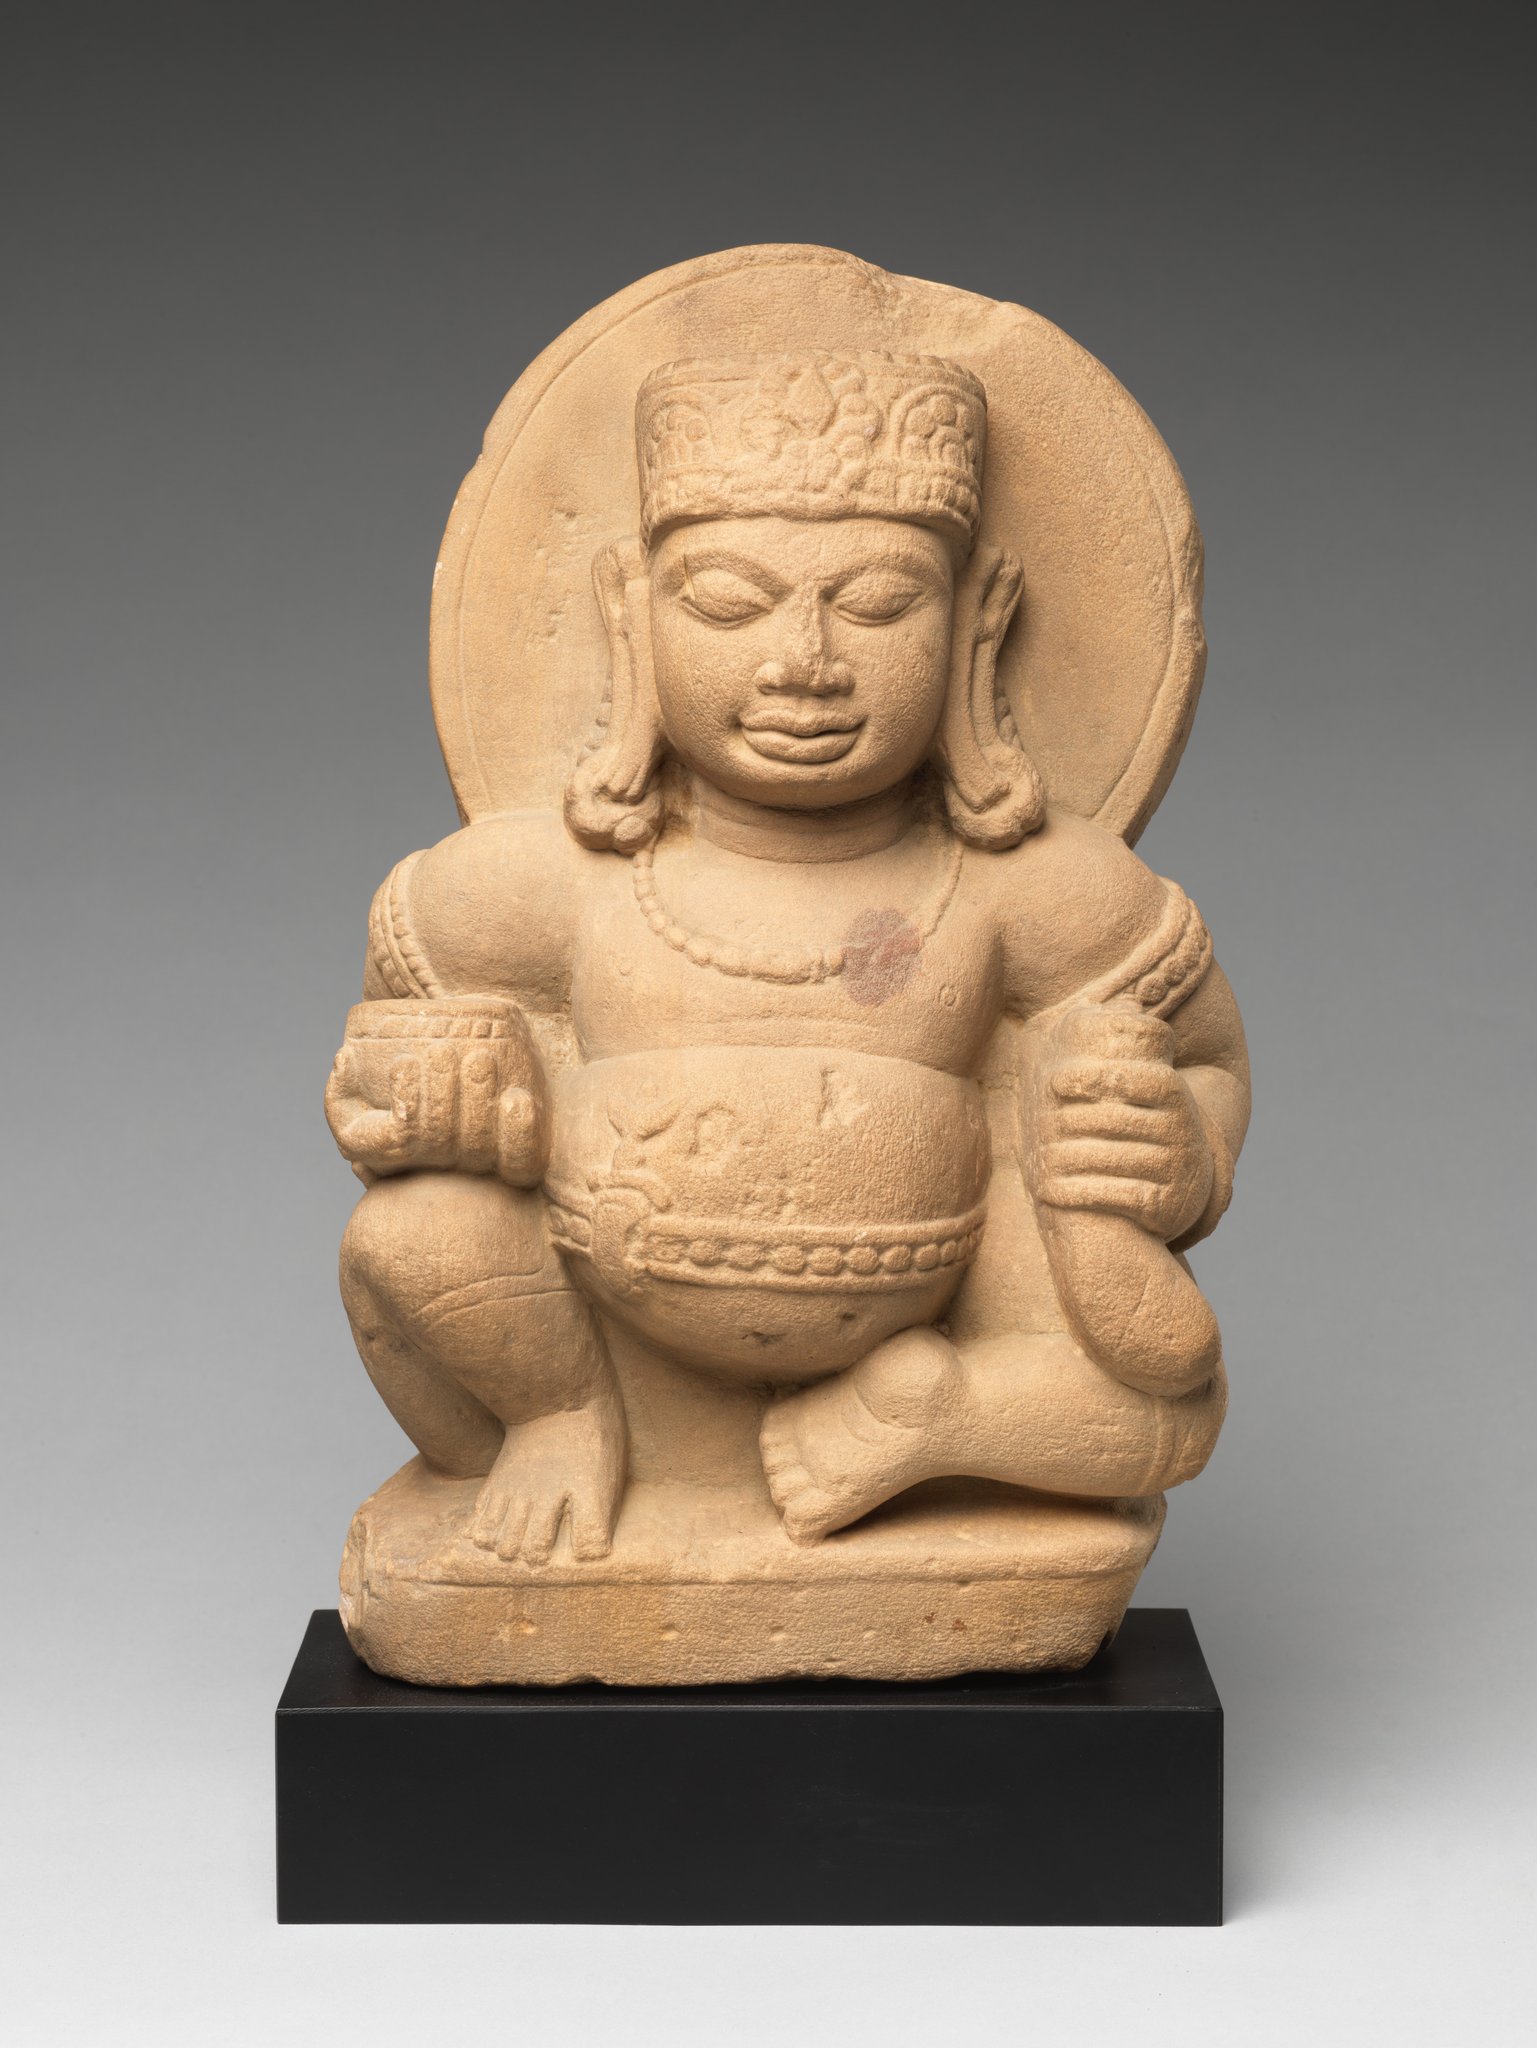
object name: figure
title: Seated Kubera (Study Collection)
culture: indian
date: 801-900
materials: stone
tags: men